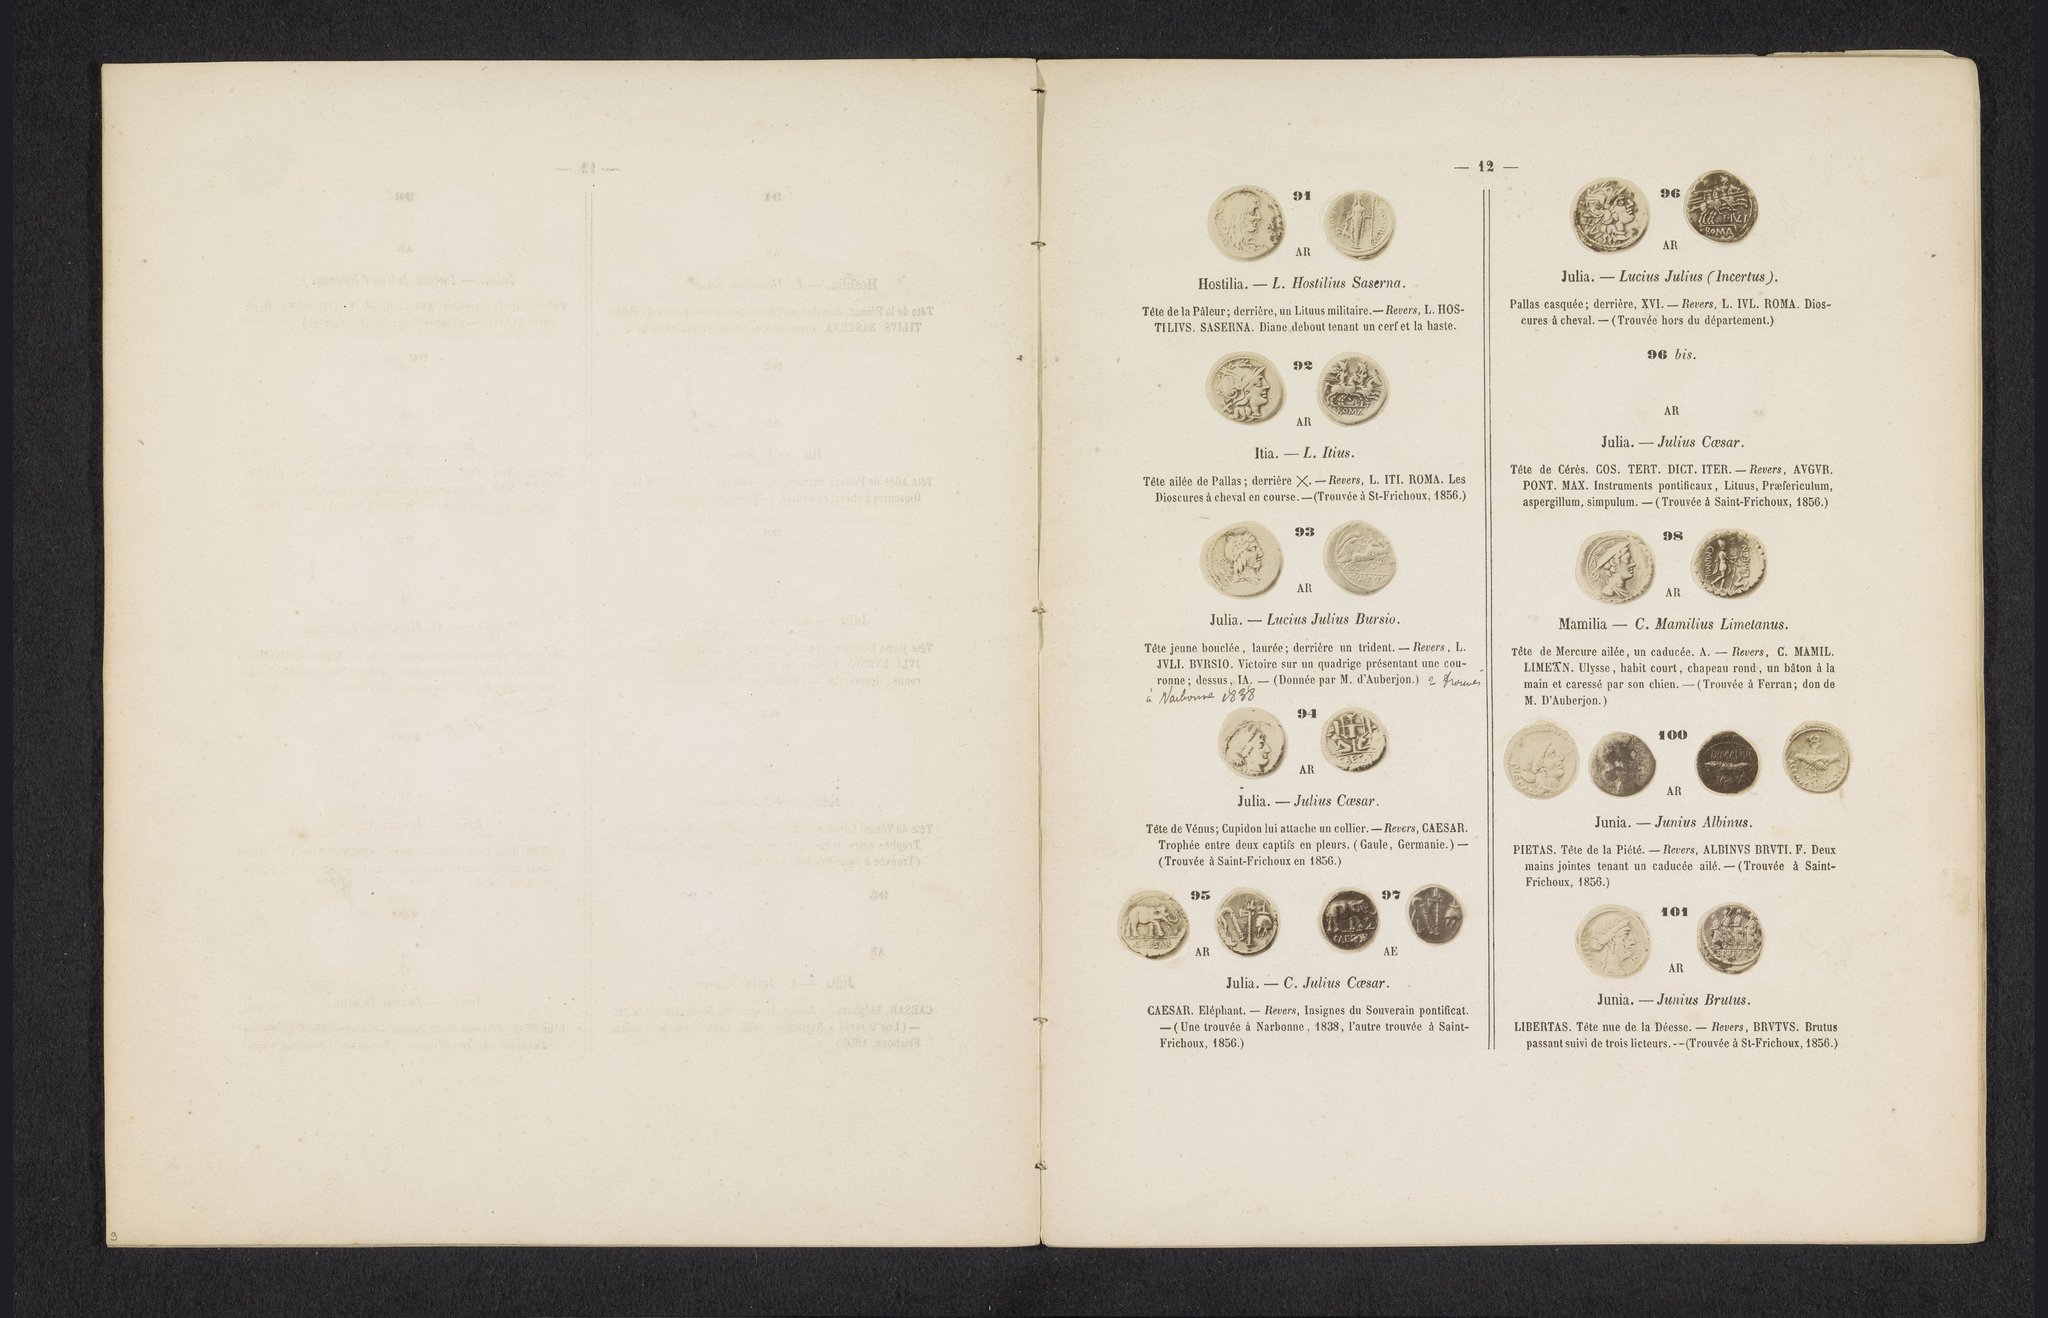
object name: photograph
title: Elf Romeinse munten, gezien van voor- en achterkant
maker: léopold verguet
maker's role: abt, fotograaf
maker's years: 1817-1914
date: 1854-1864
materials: photographic support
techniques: albumen print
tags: coin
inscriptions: number